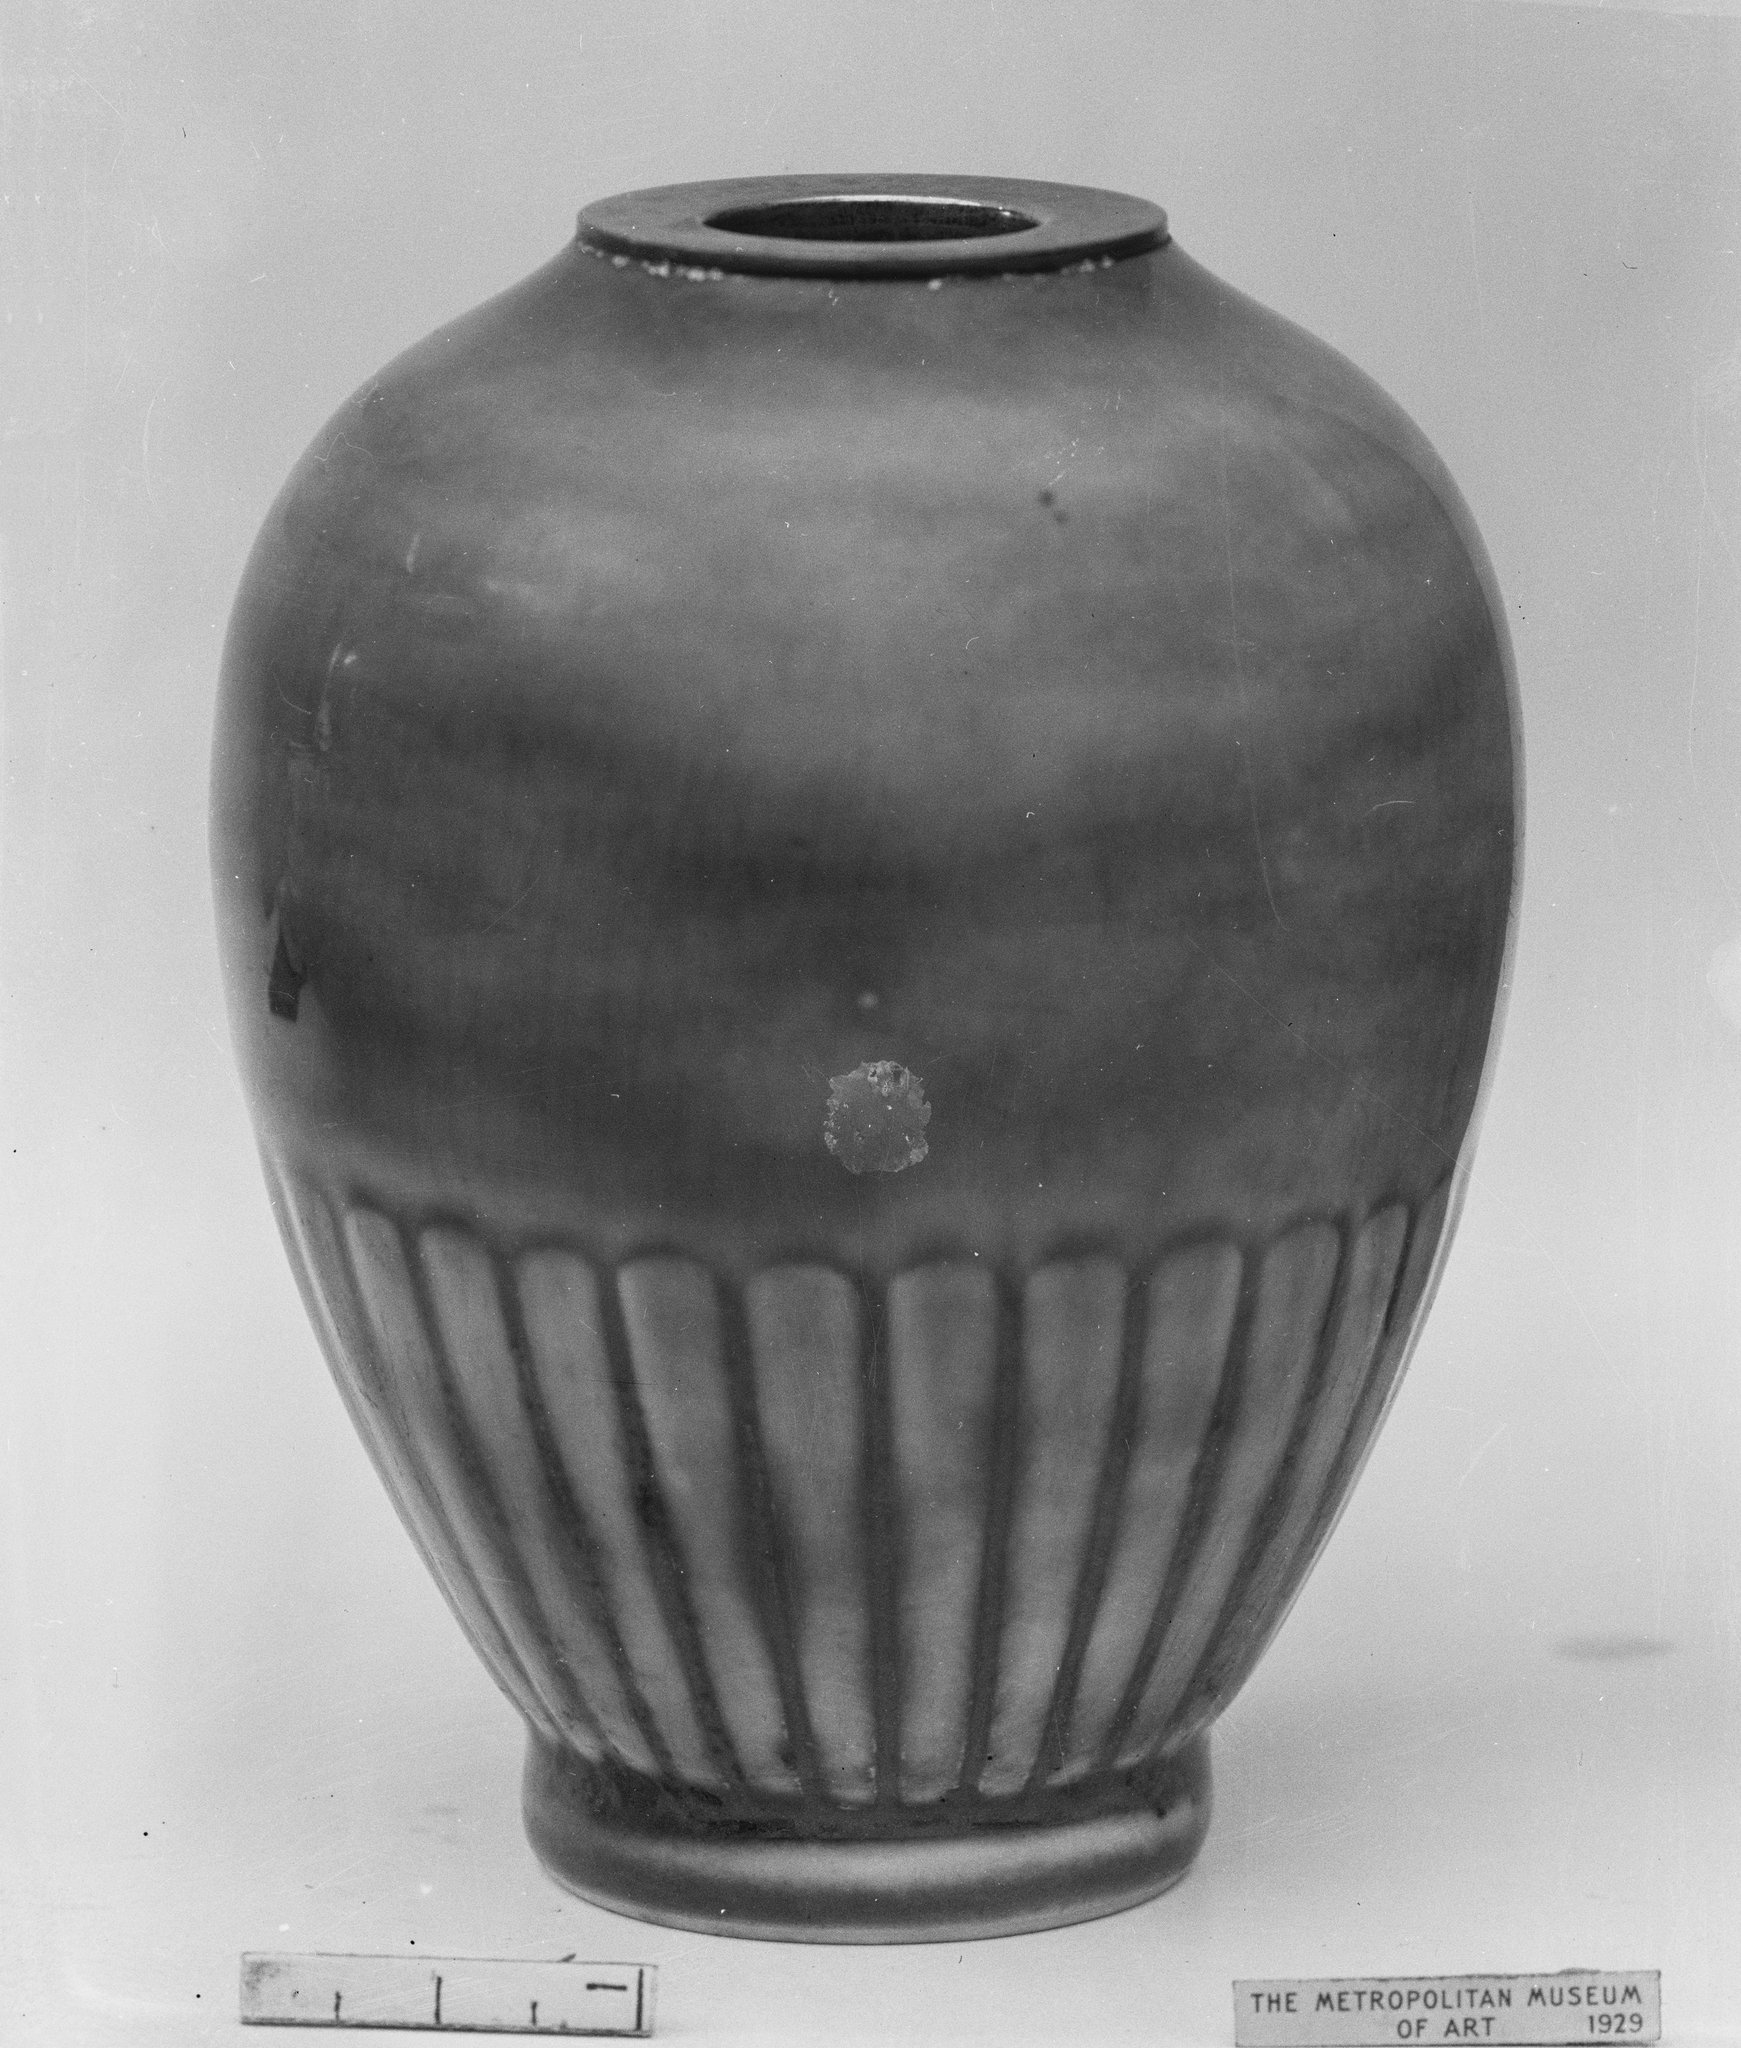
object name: coupe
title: Water Coupe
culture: chinese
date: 1662-1722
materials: glaze, porcelain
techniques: cutting